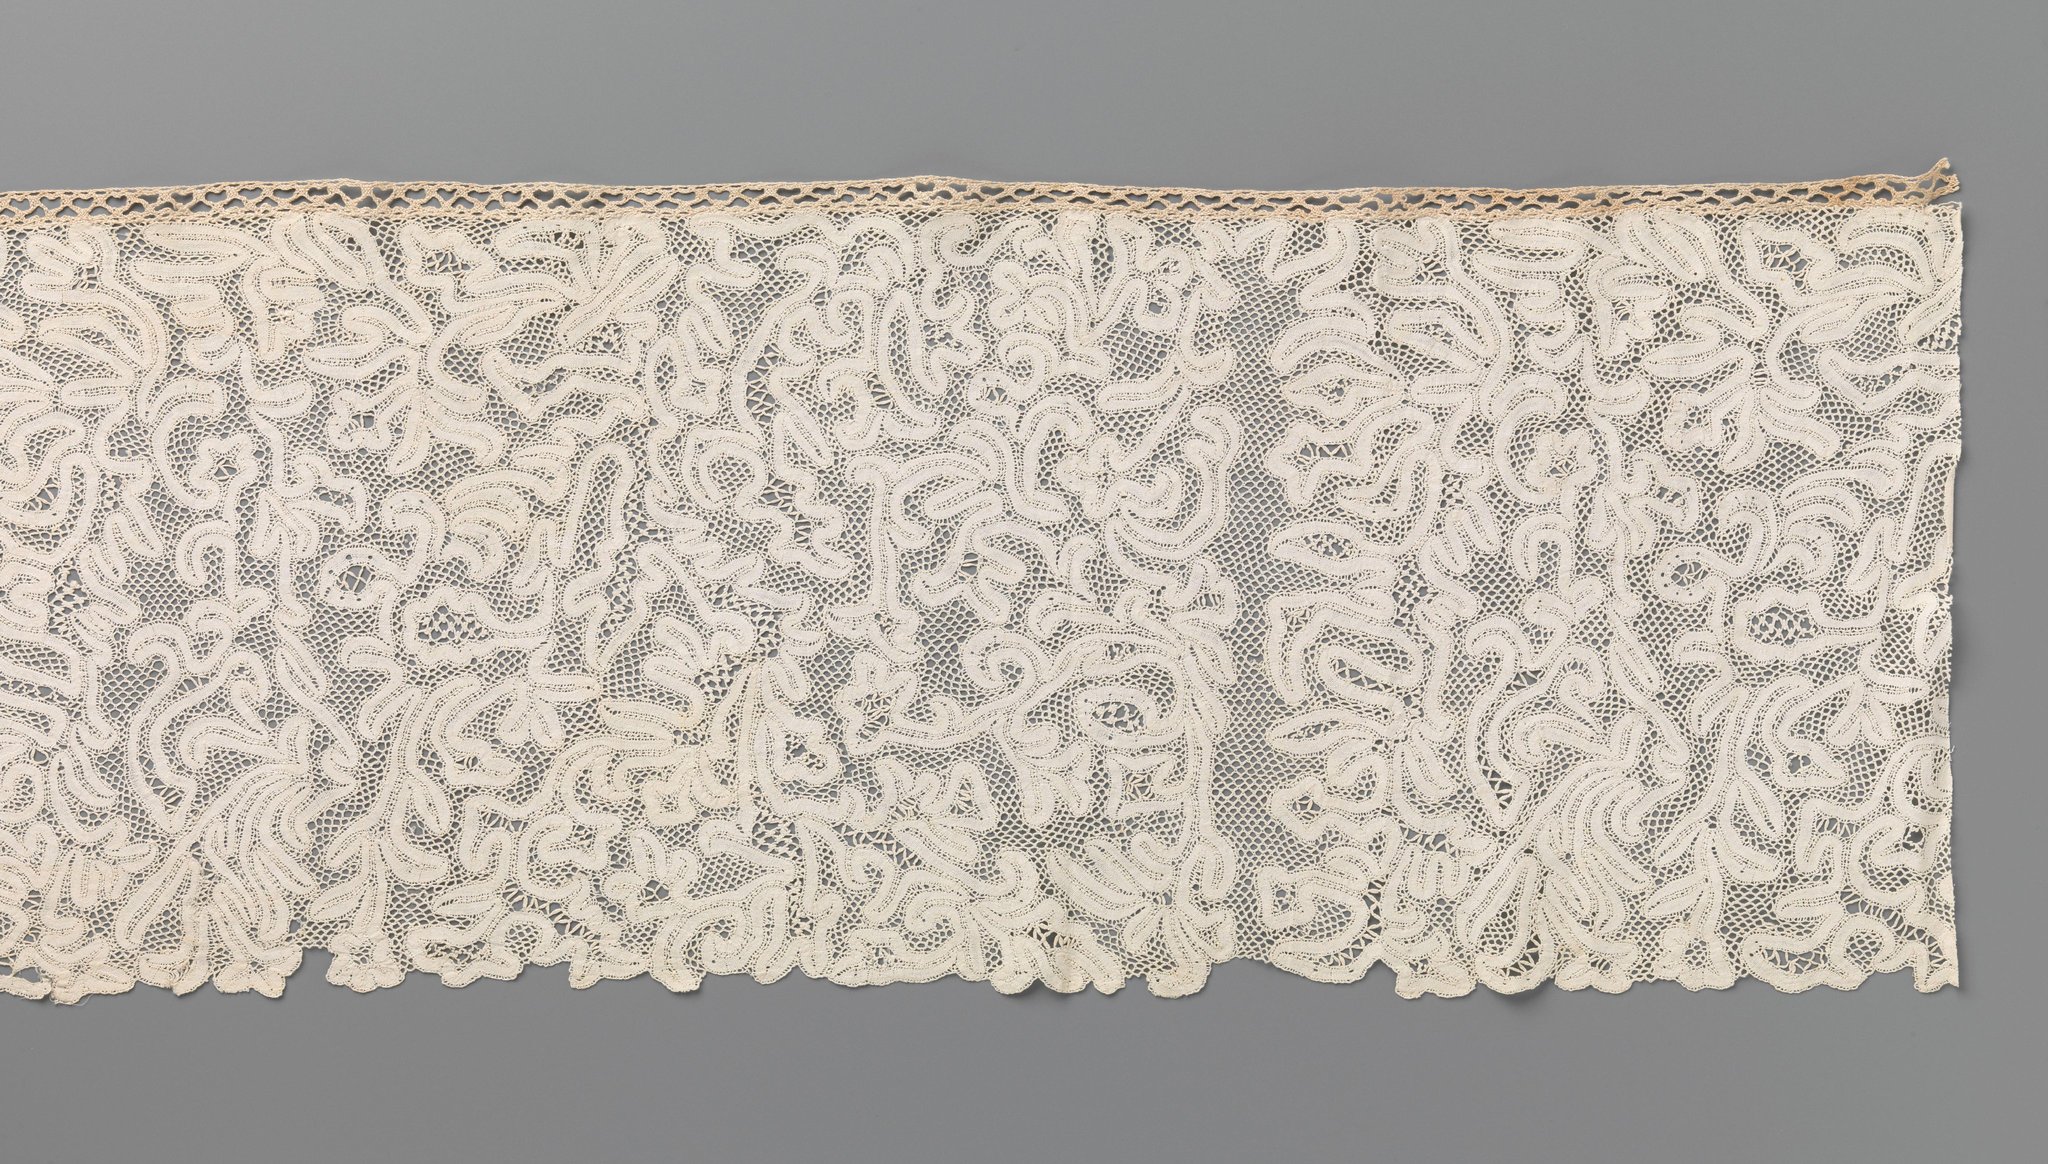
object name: albestrook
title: Strook kloskant met oneindig kronkelend lint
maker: Anonymous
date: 1700-1724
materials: linen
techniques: lace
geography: milan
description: Strook naturelkleurige kloskant, Milanese kant. De strook is gemaakt of gebruikt voor aan een superplie. Het patroon wordt door een oneindig kronkelend lint gevormd. Een herhaling van het patroon is te zien waar het lint een stukje alleen langs de bovenrand kronkelt, waardoor de maasgrond daaronder niet door het lint wordt doorsneden. Hierdoor ontstaan rechthoekige blokken, vol takken met ingesneden bladeren en bloemknoppen. De kronkels worden bij elkaar gehouden door een ruitvormige maasgrond. Het lint is gemaakt in linnenslag met opengewerkte randjes, sporadisch komen ook uitsparingen in centrum van het lint voor. In enkele bladeren en bloemen is een siergrond in vormslag gemaakt of zijn enkele gepicoteerde vlechten toegepast. De bovenzijde is afgewerkt met een apart geklost randje. De onregelmatige schulpen langs de onderzijde komen voort uit het patroon met het kronkelende lint.